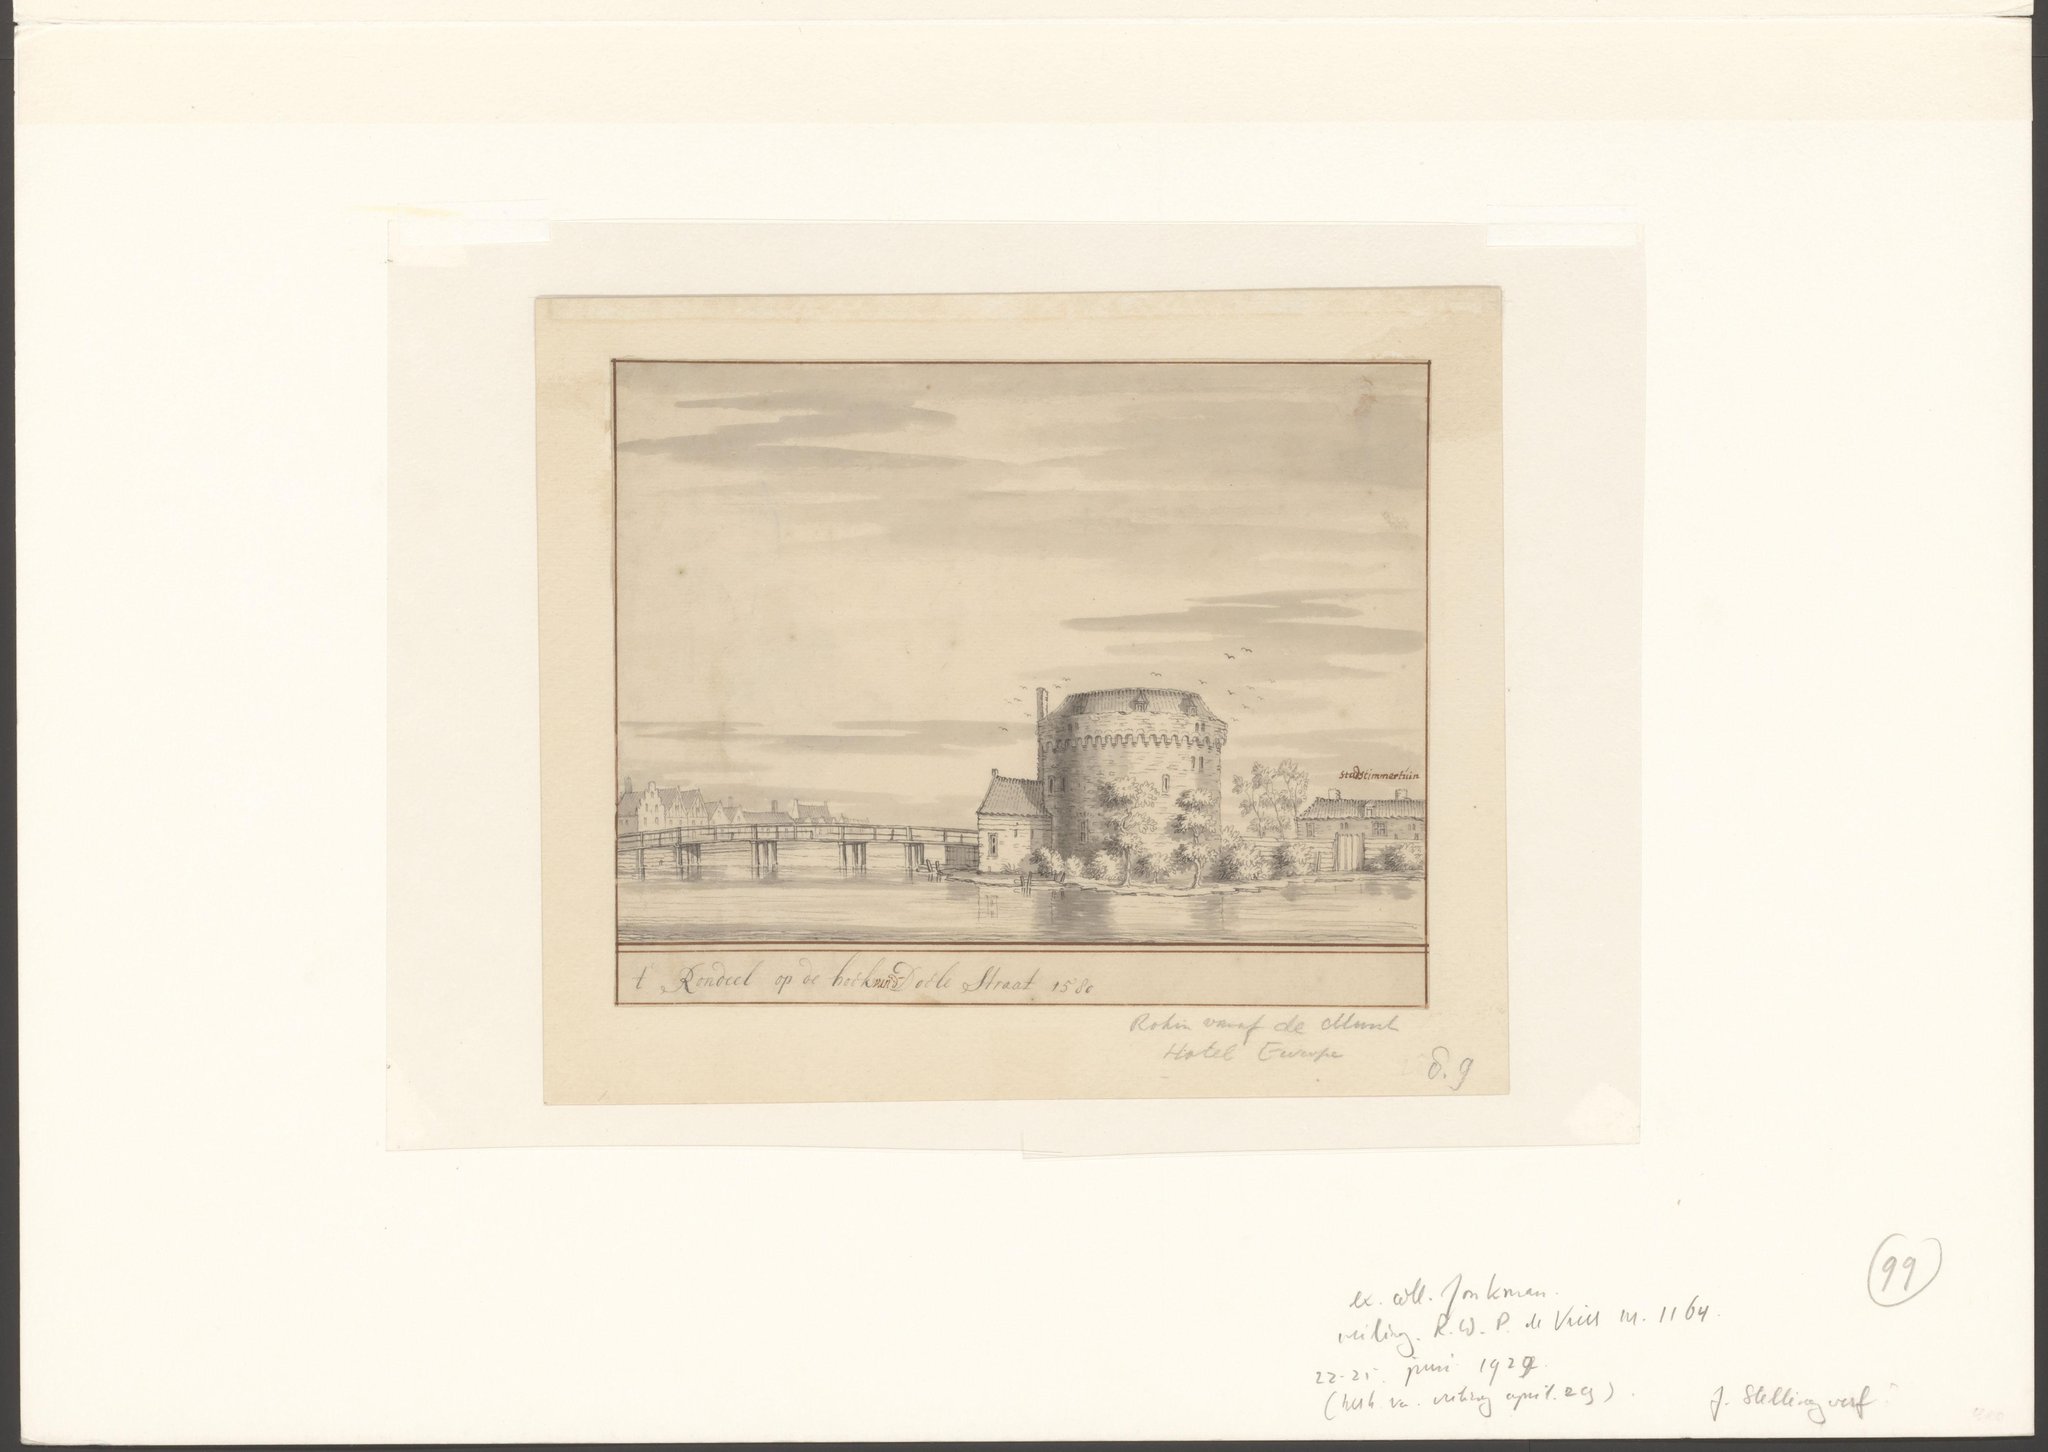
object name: drawing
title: Gezicht op het Rondeel, hoek Doelenstraat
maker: jacobus stellingwerff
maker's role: draughtsman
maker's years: 1660-1736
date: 1670-1736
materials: ink, paper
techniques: brush, pen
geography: amsterdam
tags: city-view in general; 'veduta', towers ~ fortified city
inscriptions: inscription: ‘Rokin vanaf de Munt / Hotel Europa / 8.9’, inscription: ‘ex. coll. Jonkman (...) J. Stellingwerff’, inscription: ‘stadstimmertuin / t Rondeel op de hoek van d Doele Straat 1580’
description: Onderwerpsrubriek binnen de Atlas Amsterdam: Vestingwerken: Bolwerken - Rondeel - Wachttorens - Blokhuizen - Kazematten - Ontwerpen Kostuum Alva.